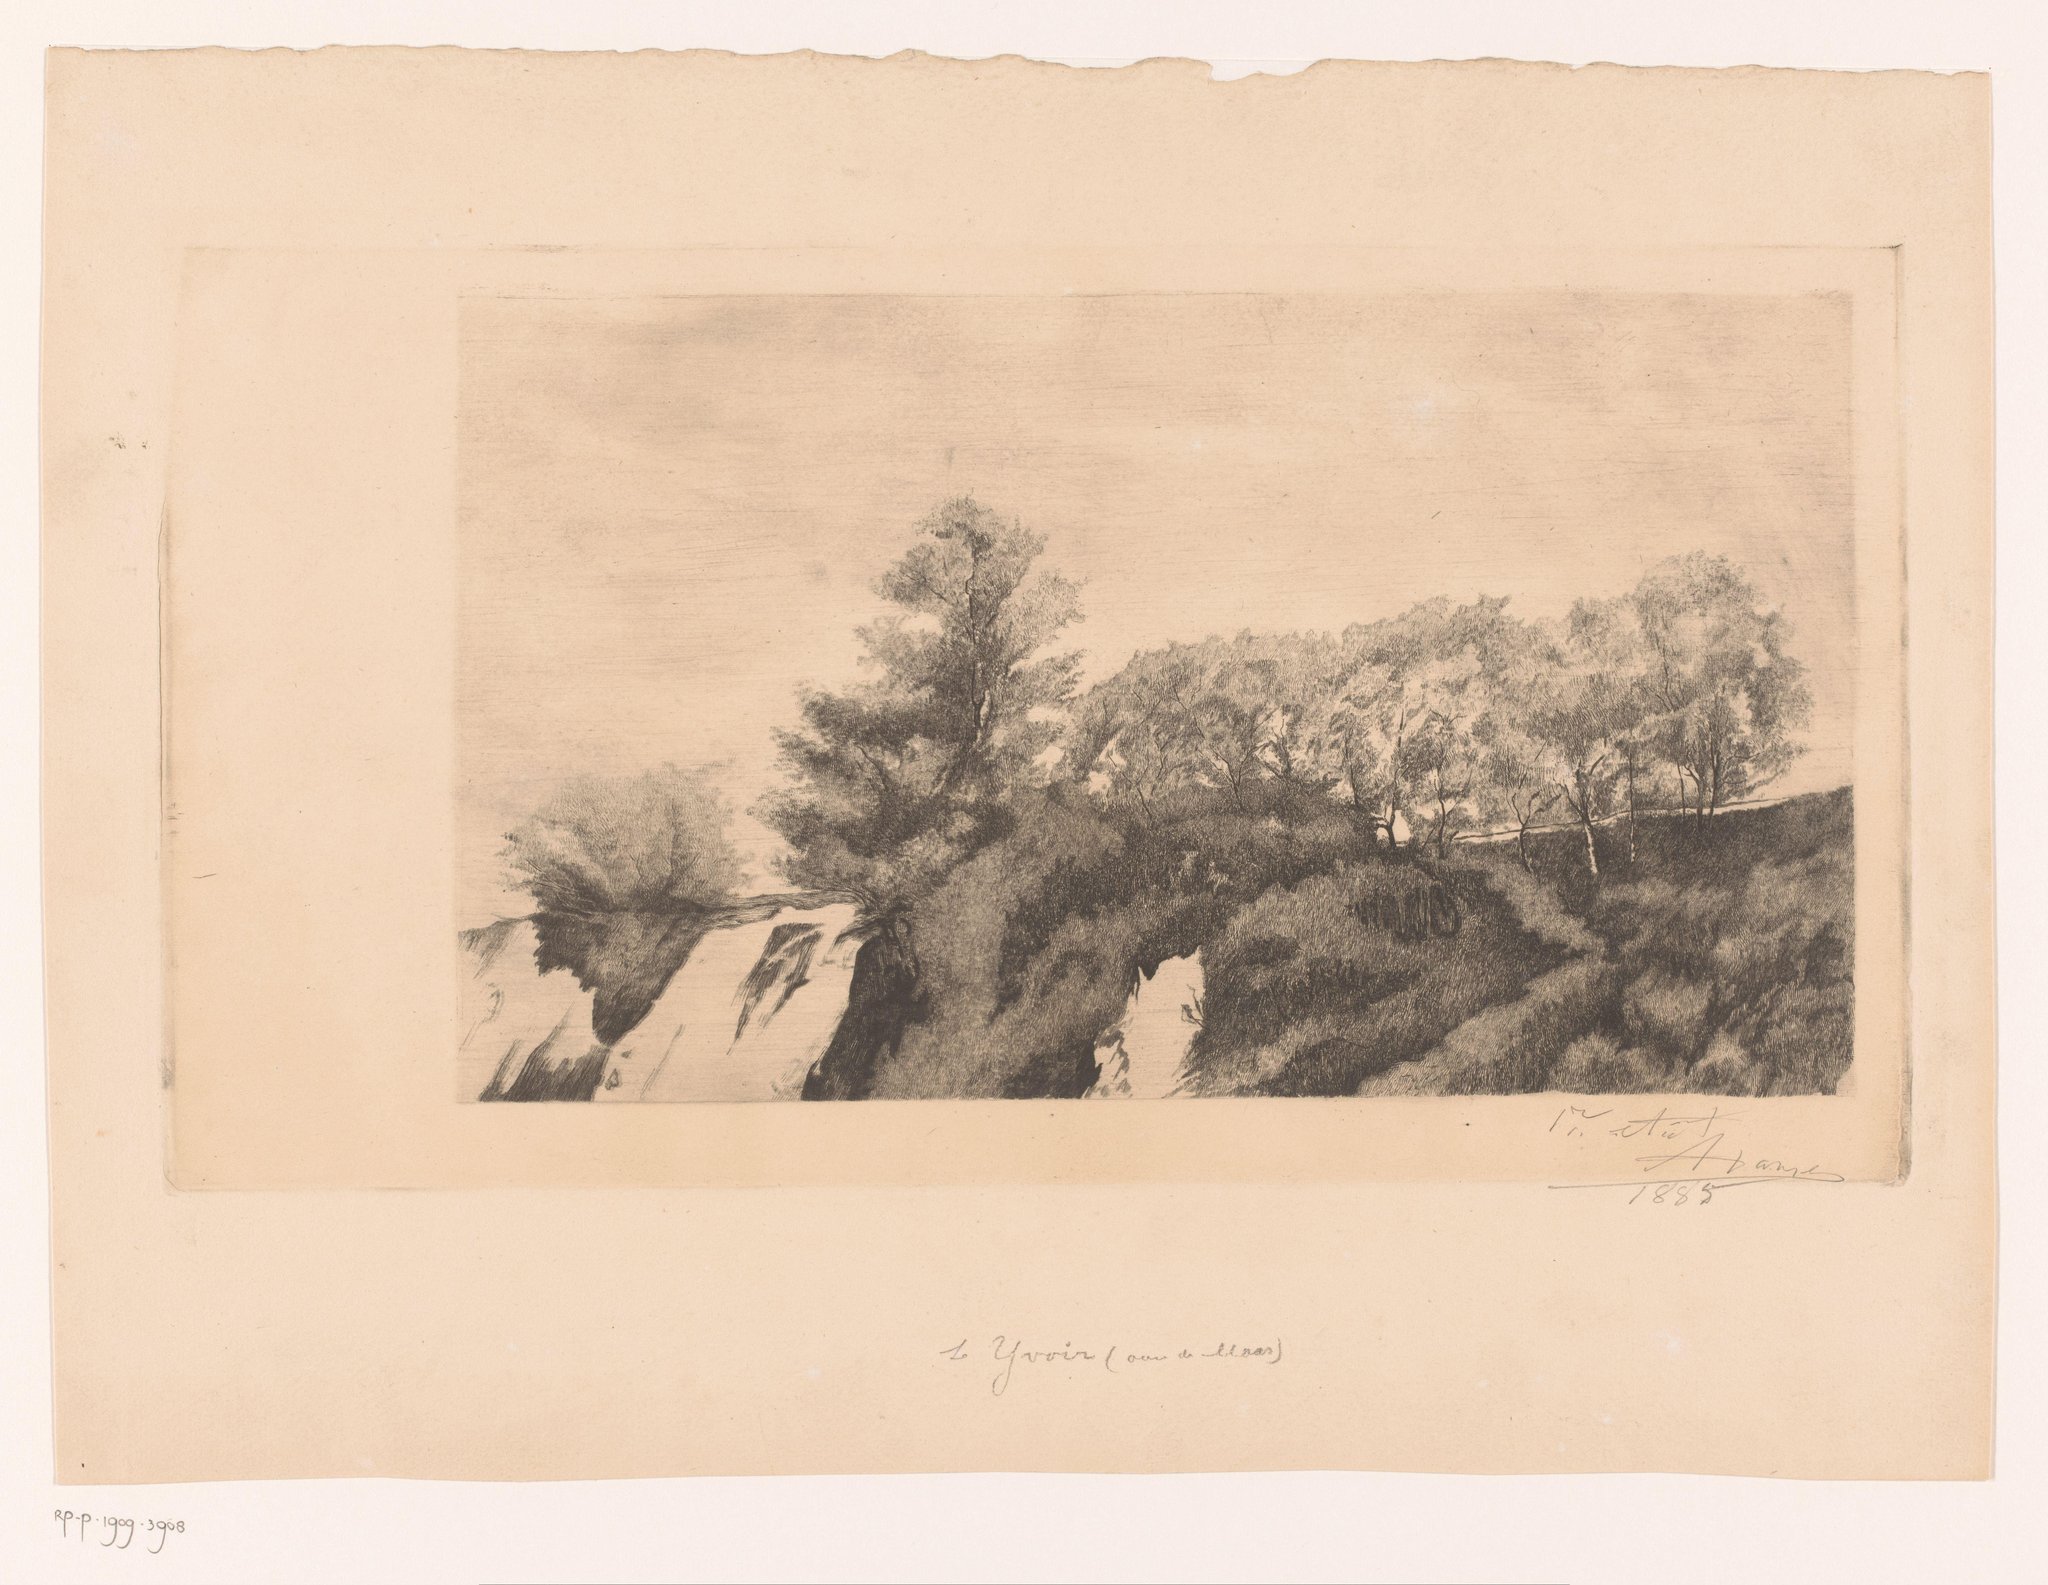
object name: print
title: Landschap bij Yvoir aan de oever van de Maas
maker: auguste danse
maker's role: print maker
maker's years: 1829-1929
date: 1885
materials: paper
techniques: etching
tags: landscapes in the temperate zone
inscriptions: annotation: ‘1er etat’, collector's mark: Lugt 2228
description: De lokalisering Yvoir is gebaseerd op de potloodaantekening in de ondermarge.